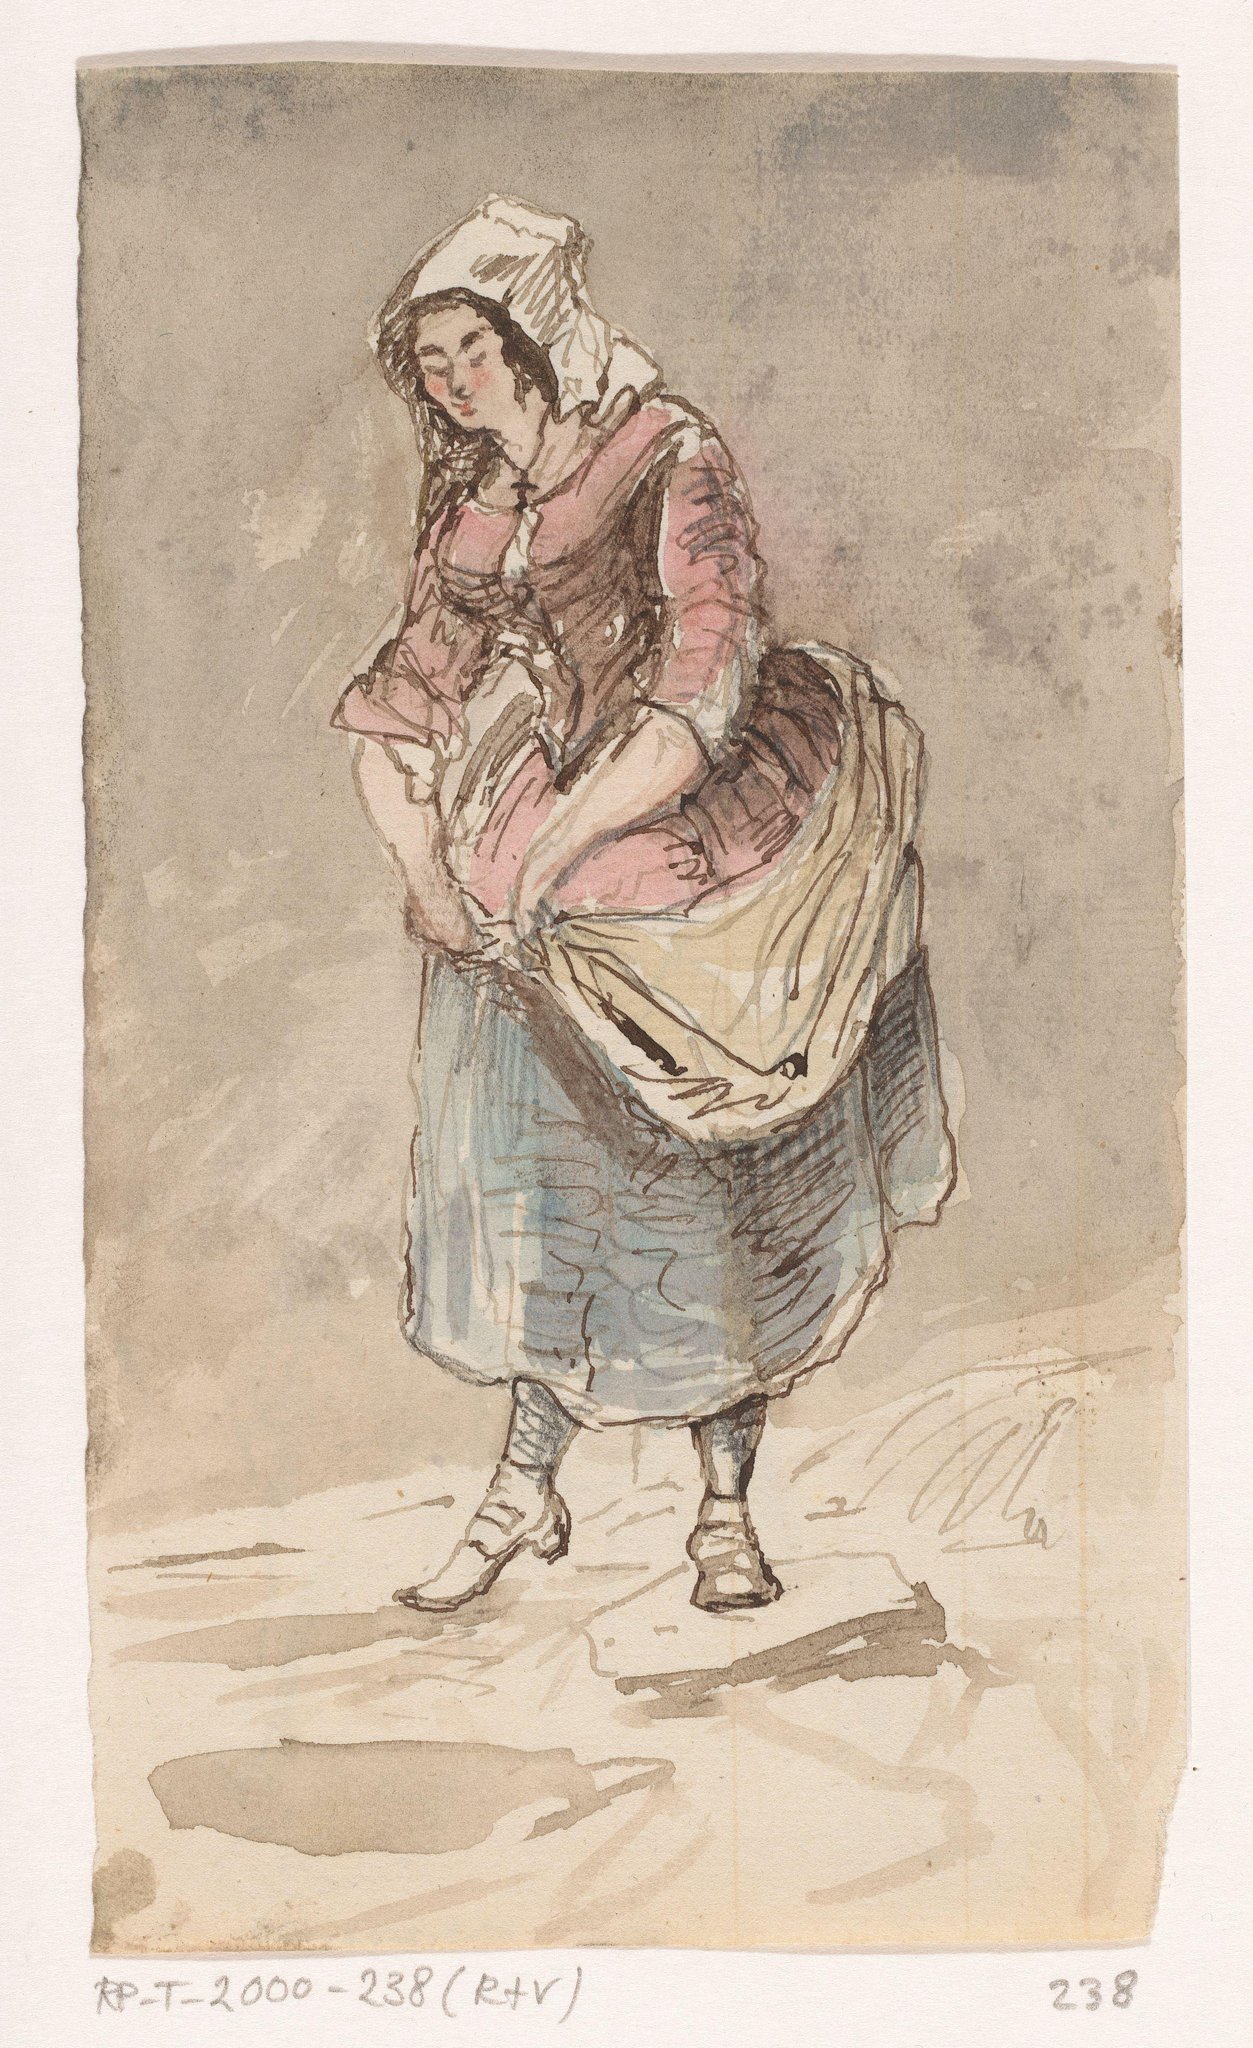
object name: drawing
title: Vrouw met schort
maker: johannes tavenraat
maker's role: draughtsman, painter, print maker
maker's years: 1809-1881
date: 1840-1880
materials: ink, paper, watercolor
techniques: brush, pen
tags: apron, folk costume, regional costume